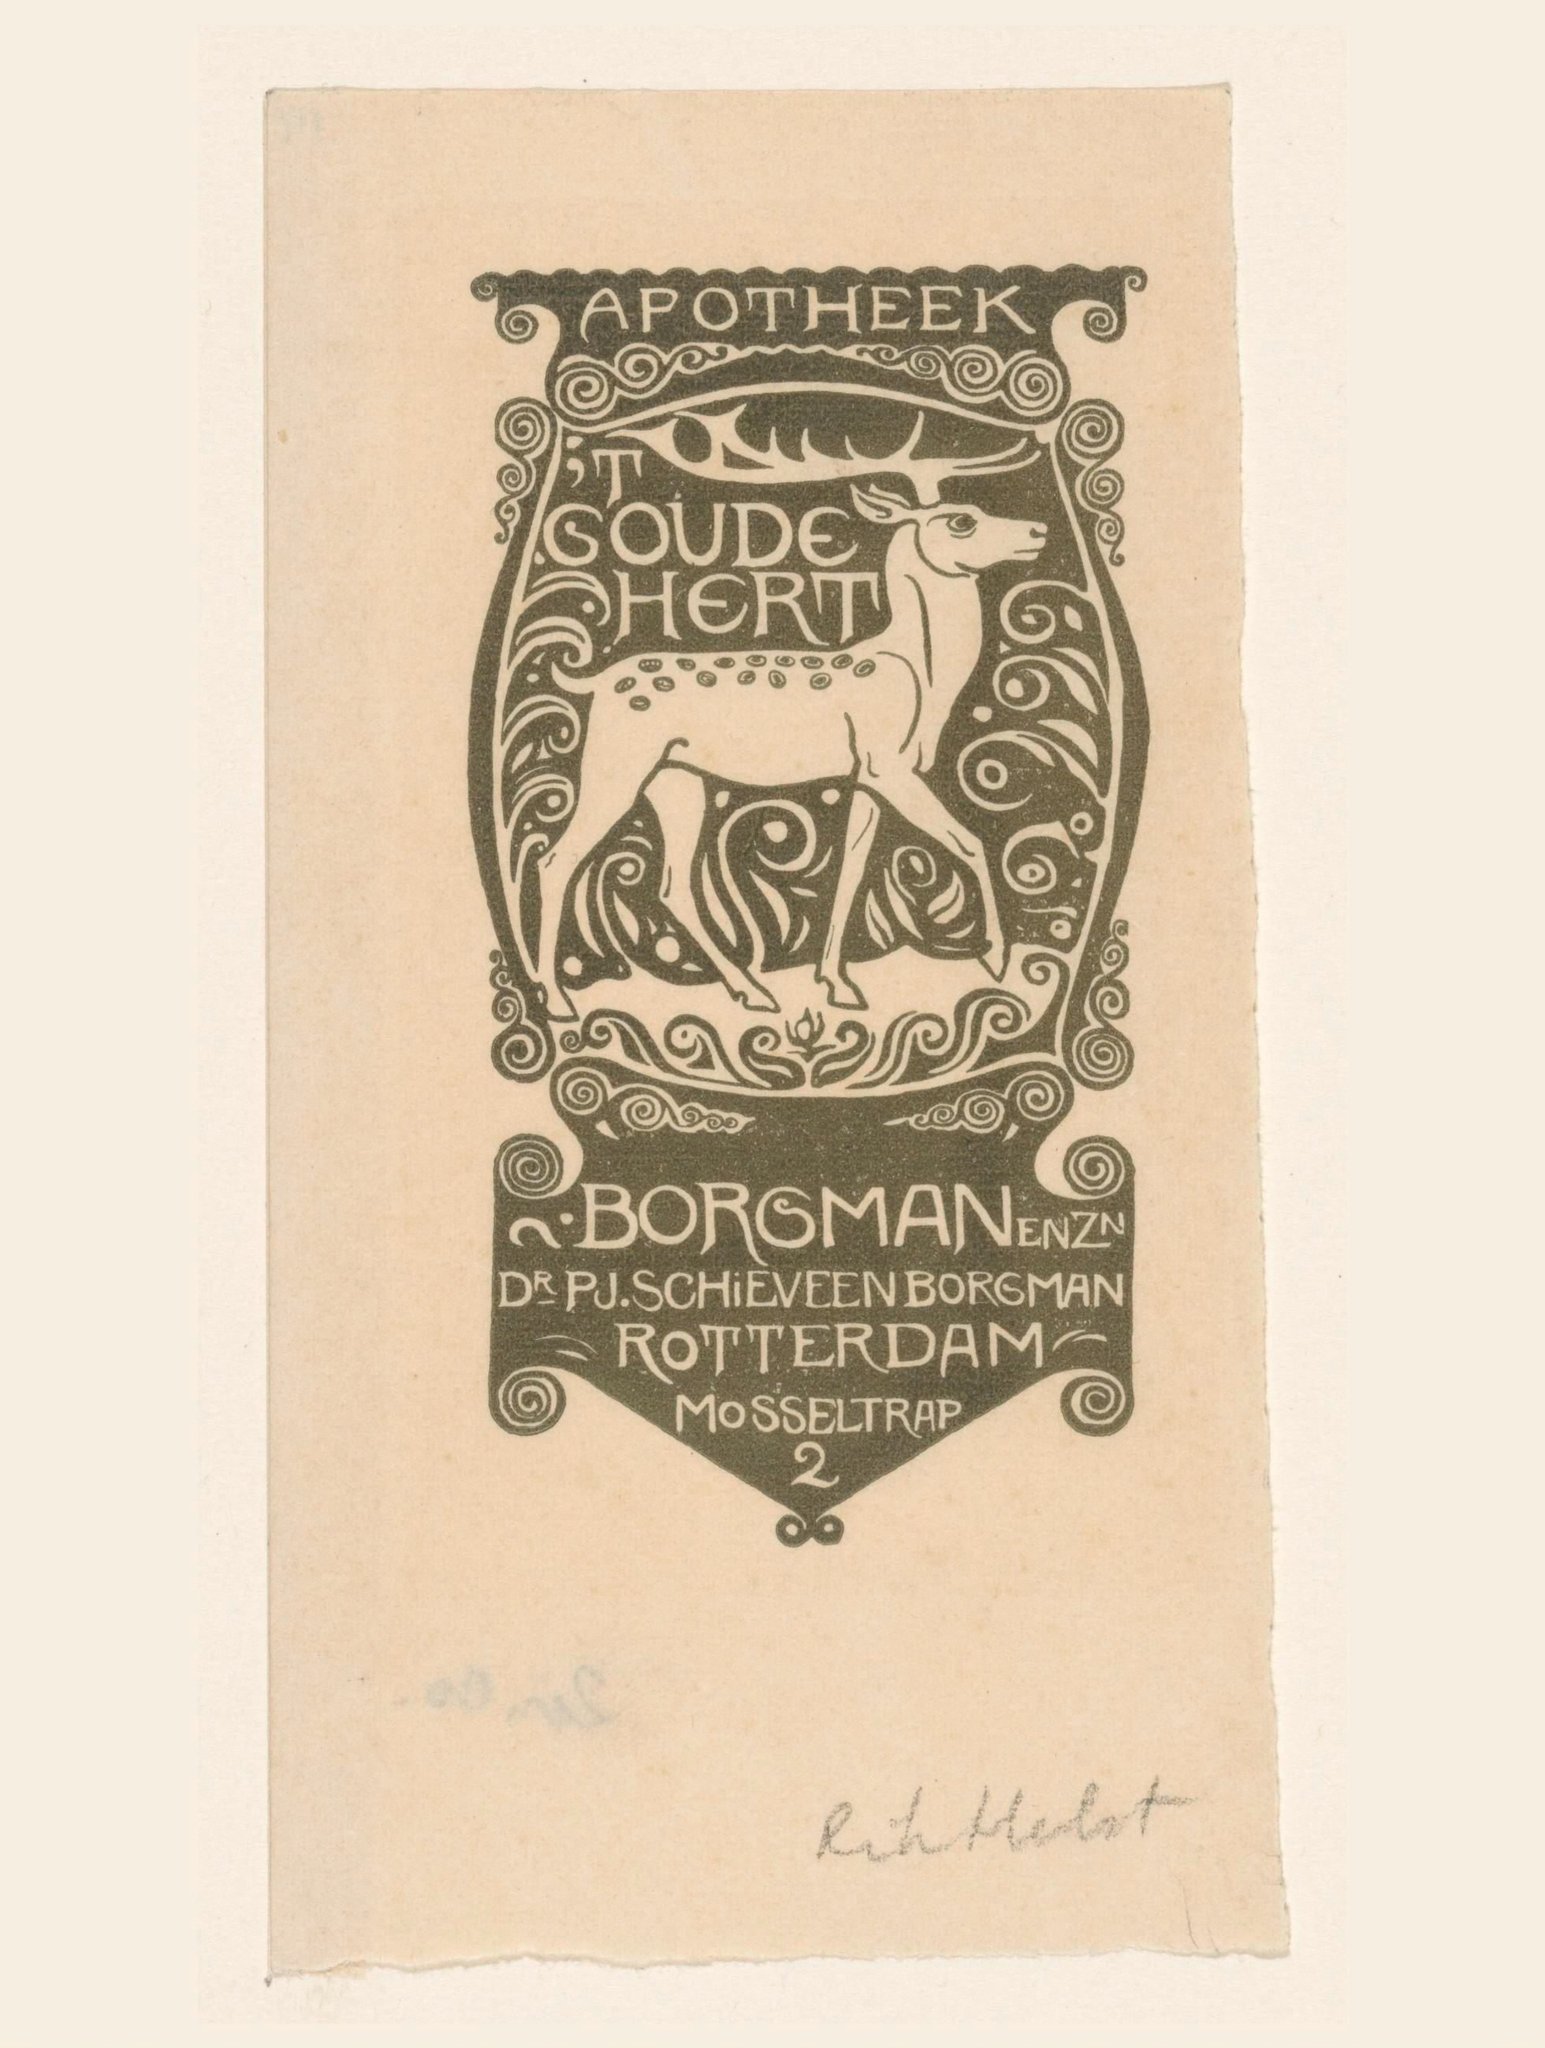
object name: print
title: Apotheek 't Goude Hert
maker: richard nicolaüs roland holst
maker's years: 1868-1938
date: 1910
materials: paper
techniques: line block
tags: hoofed animals: deer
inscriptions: inscription: ‘[...]co’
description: Onderaan de contactgegevens van 't Goude Hert: 'Borgman en Zn. / Dr. P.J. Schieveen Borgman / Rotterdam / Mosseltrap 2'.